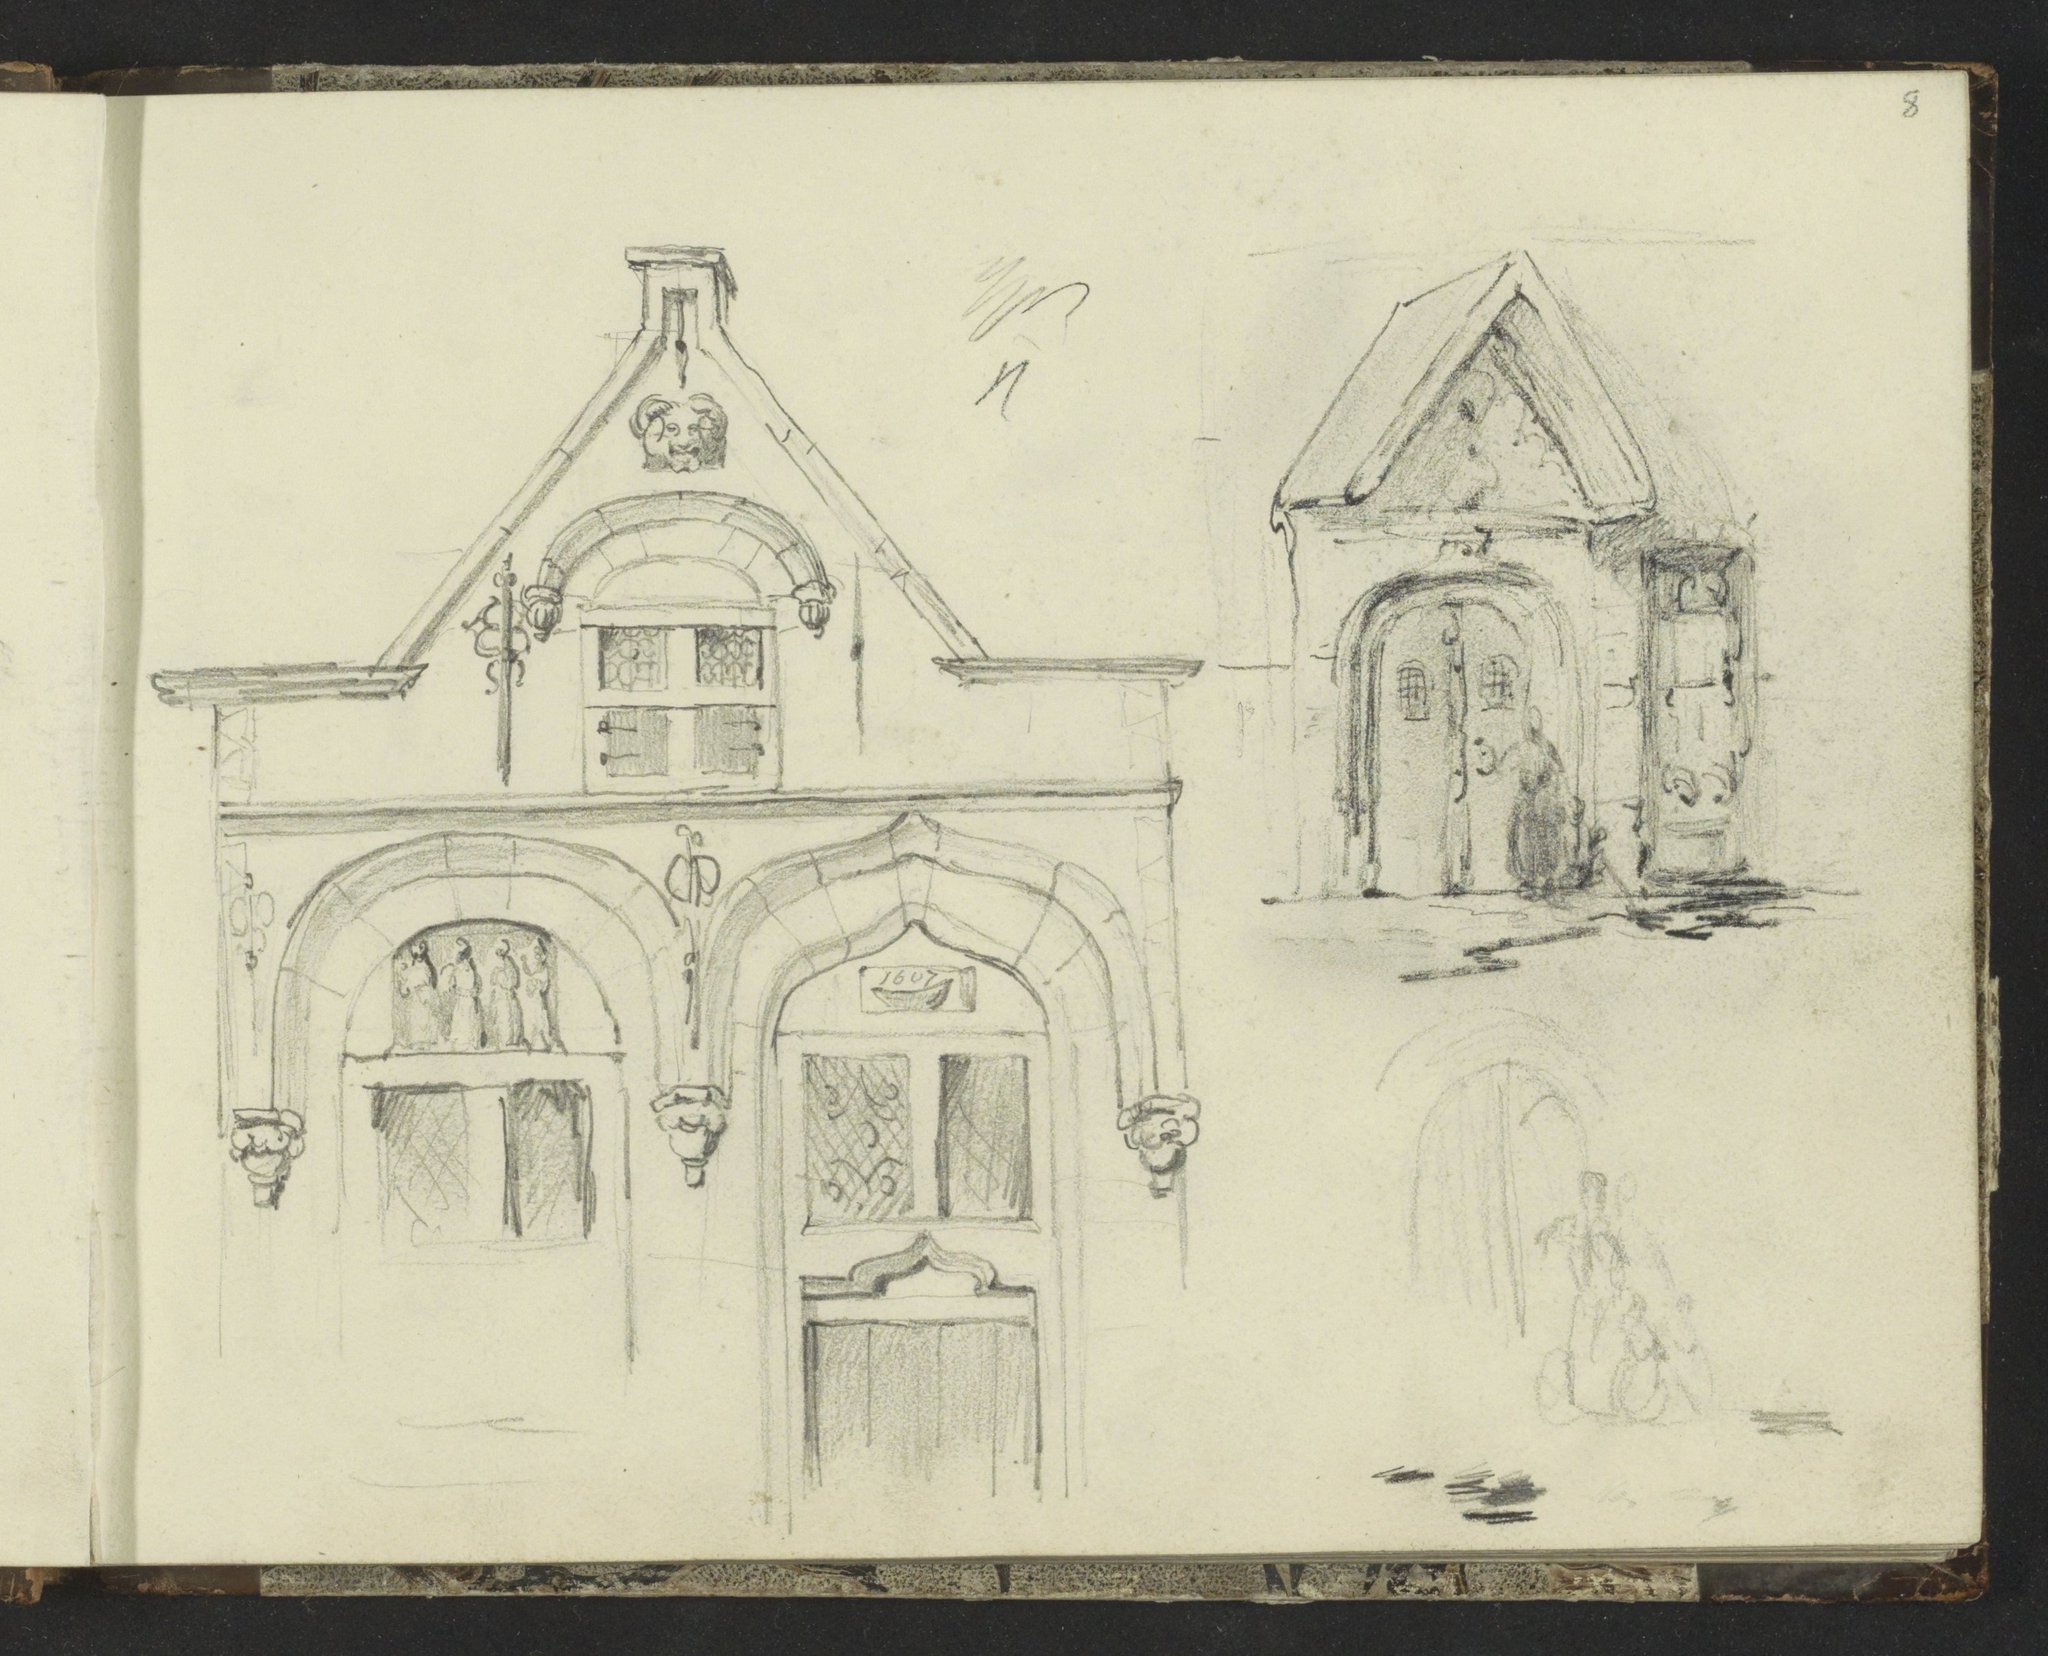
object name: sketchbook leaf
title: Façade van huis met een tuitgevel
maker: willem hendrik schmidt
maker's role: draughtsman, painter, print maker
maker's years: 1809-1849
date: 1819-1849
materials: paper, pencil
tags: gate, entrance, front façade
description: Tevens twee studies van vrouwen bij portalen. Blad 8 recto uit een schetsboek met 58 bladen.